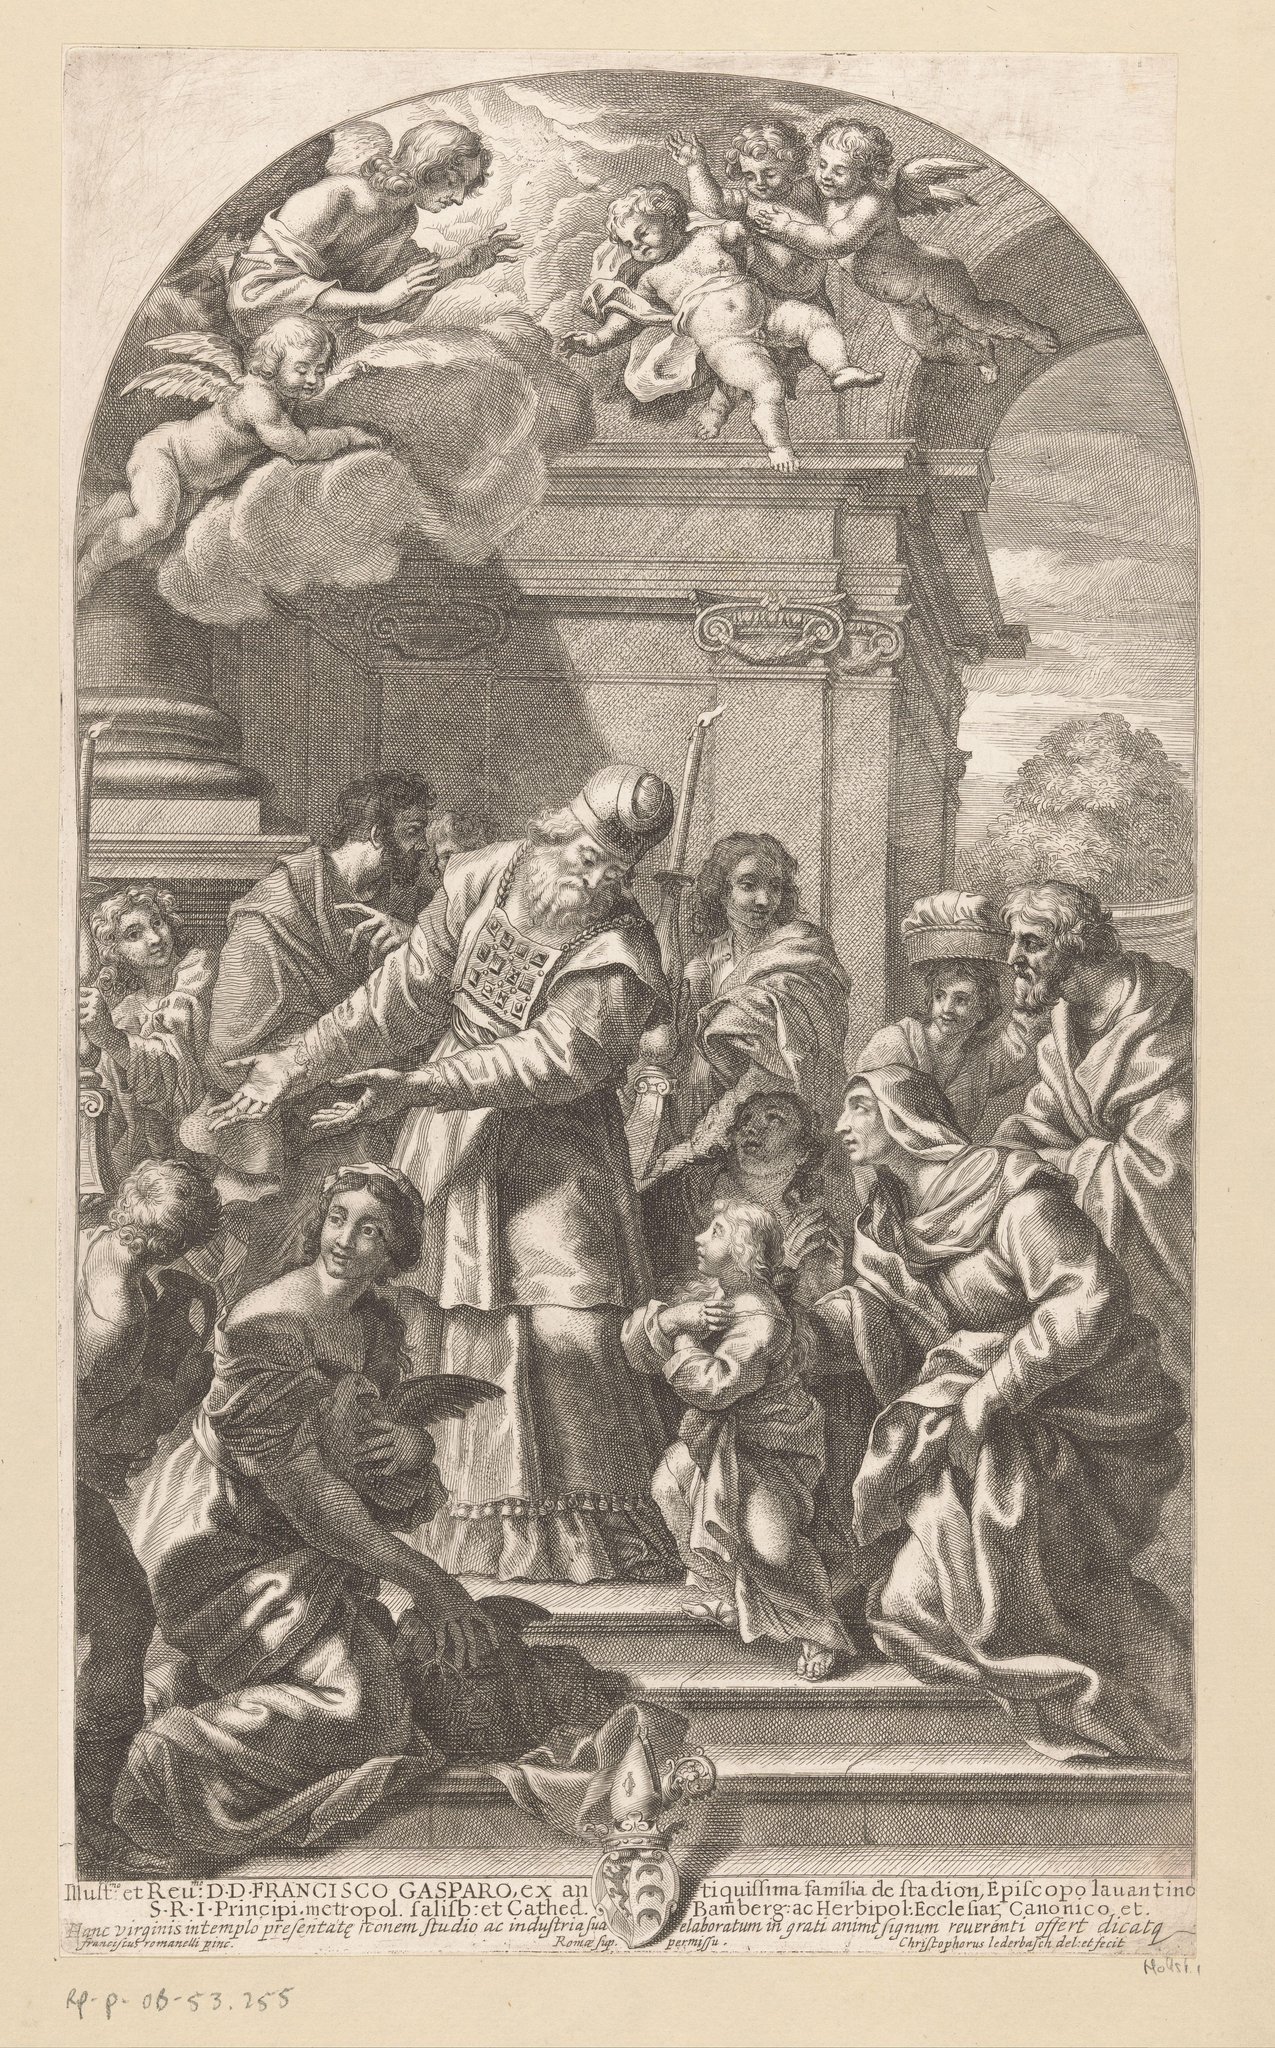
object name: print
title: Presentatie van Maria in de tempel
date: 1661-1705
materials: paper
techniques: engraving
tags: armorial bearing, heraldry, presentation of the christ-child in the temple, usually simeon (and anna) present (luke 2:22-39)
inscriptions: collector's mark: Lugt 240